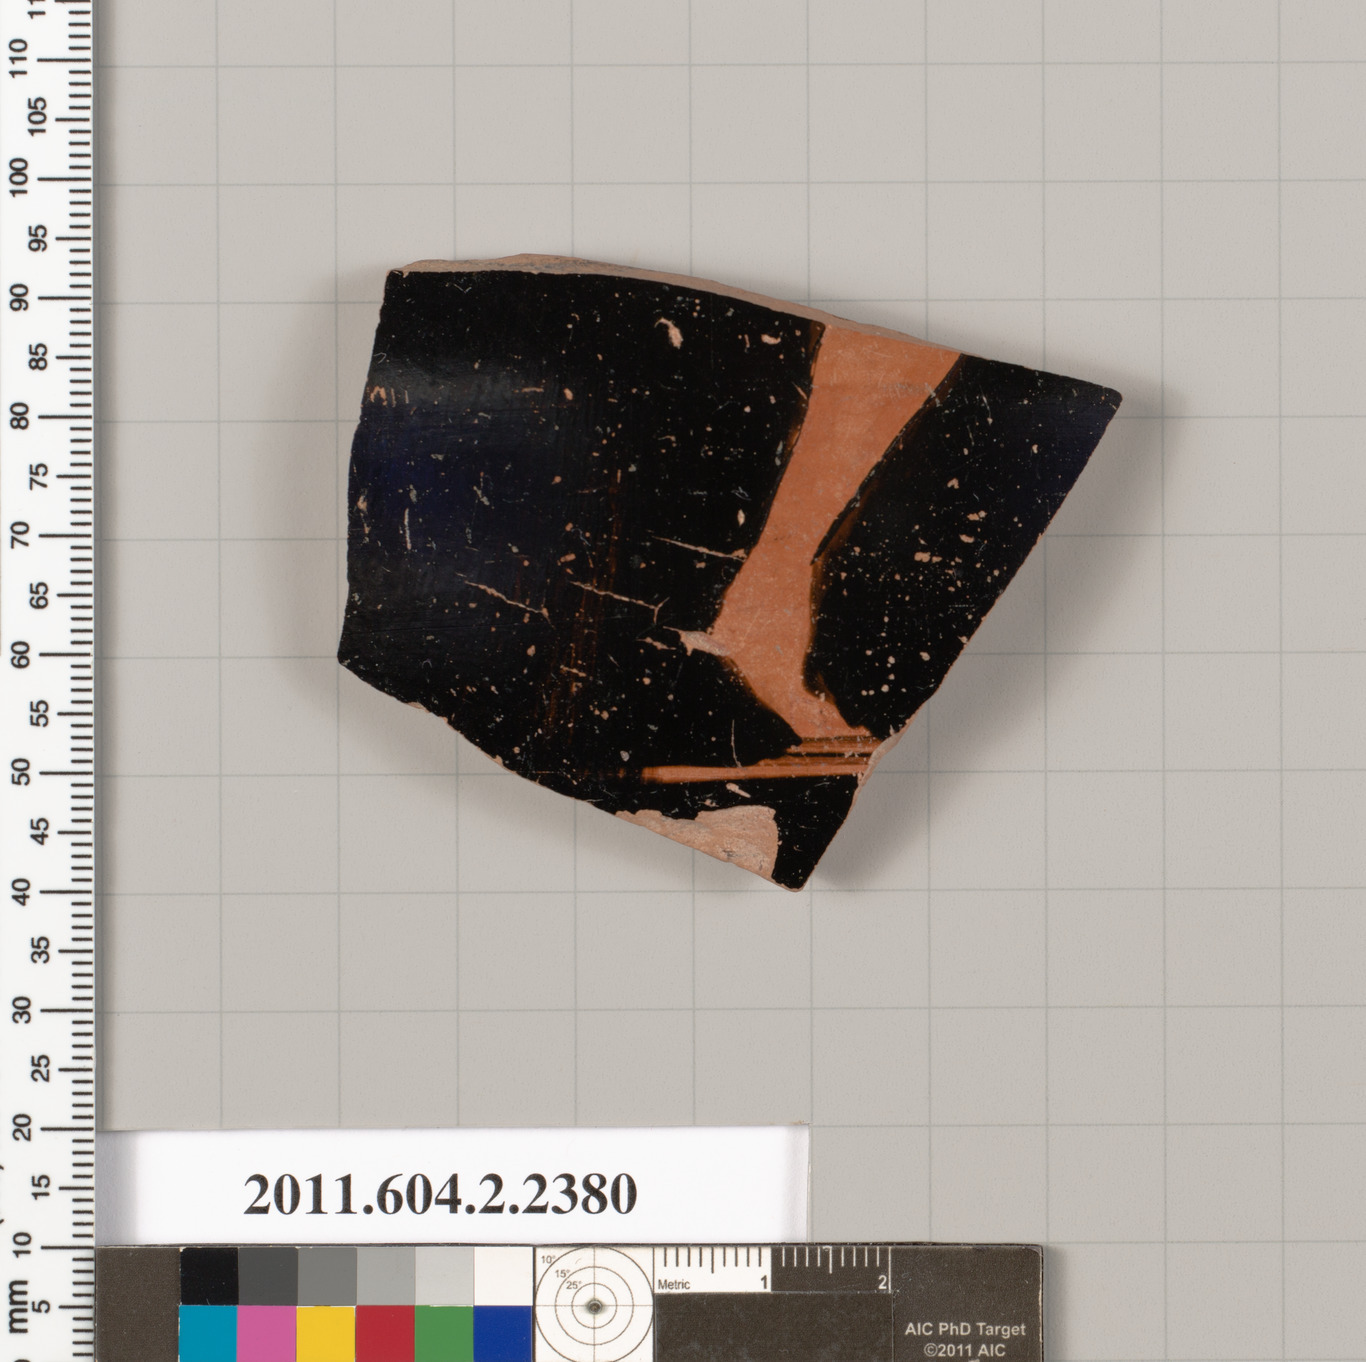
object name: chou fragment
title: Terracotta fragment of an oinochoe: chous (jug)?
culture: greek, attic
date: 460-450 BCE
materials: terracotta